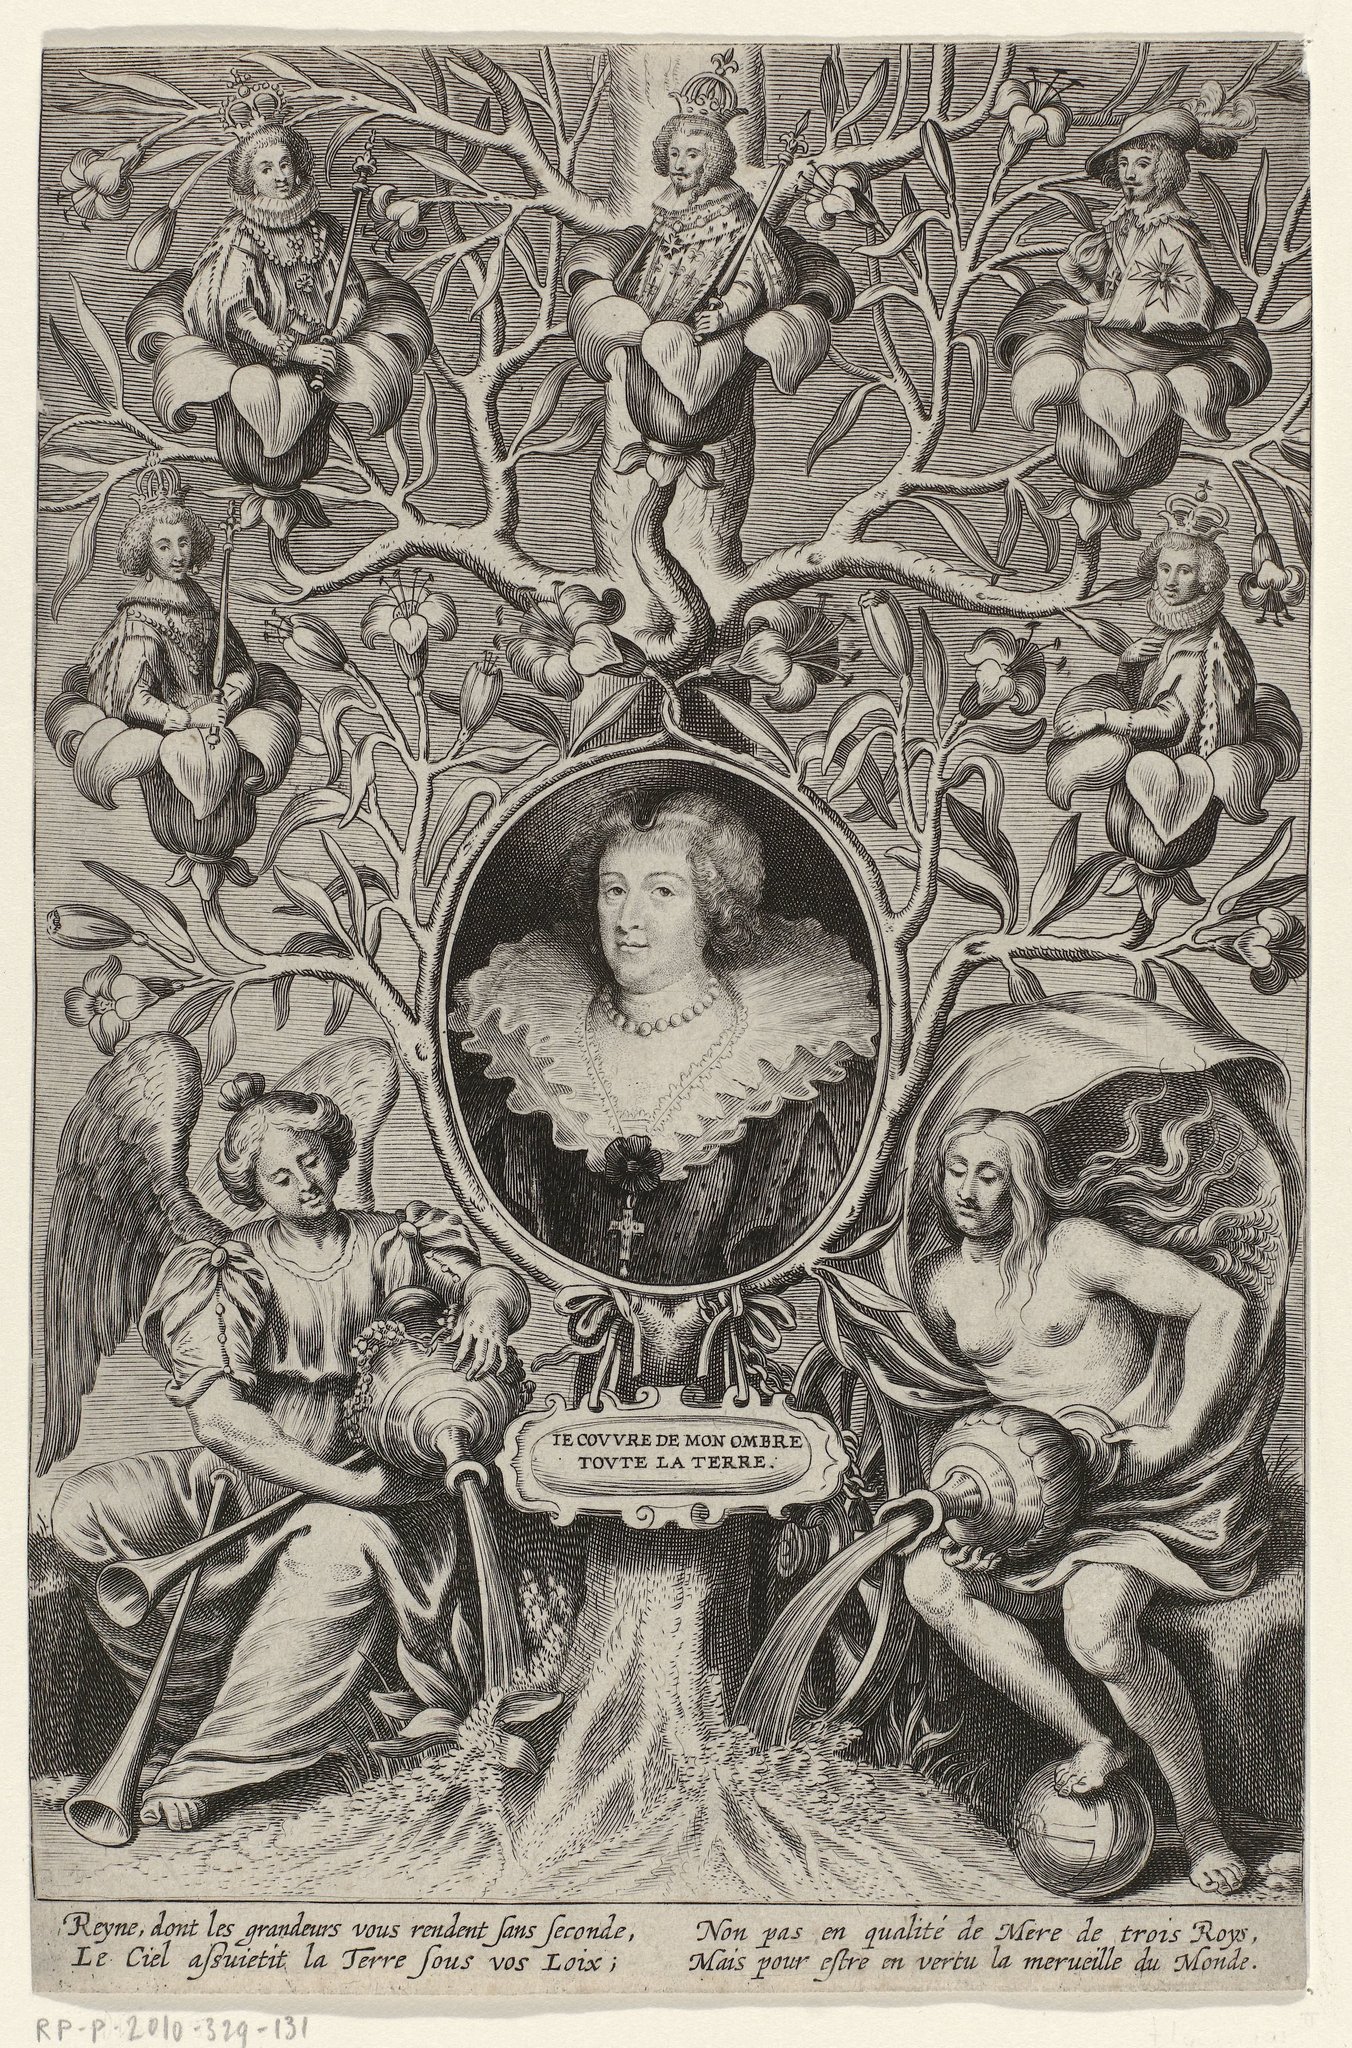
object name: print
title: Portrait of Maria de’ Medici with Family Tree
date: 1619-1632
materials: paper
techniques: engraving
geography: antwerp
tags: cologne, maria de' medici, series of rulers - bb - female ruler, family lineage, pedigree, genealogical tree or table, luck, fortune, lot; 'fato', 'fortuna', 'fortuna aurea', 'fortuna buona', 'fortuna pacifica overo clemente', 'sorte' (ripa), fame; 'fama', 'fama buona', 'fama chiara' (ripa)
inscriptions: caption: ‘Reyne, dont les grandeurs vous rendent sans seconde....Mais vous estre en vertu la merveille du Monde.’, collector's mark, motto: ‘Je couvre de mon ombre toute la terre.’, number: ‘No. 6372’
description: Sometimes several printmakers joined forces to create a portrait print. In the case of this one of Maria de’ Medici, Lucas Vorsterman engraved the central portrait of the ruler with extreme finesse. Comparatively more coarsely executed, the family tree and the personifications of Fame and Wealth are most likely the work of an engraver from Cornelis Galle’s workshop.